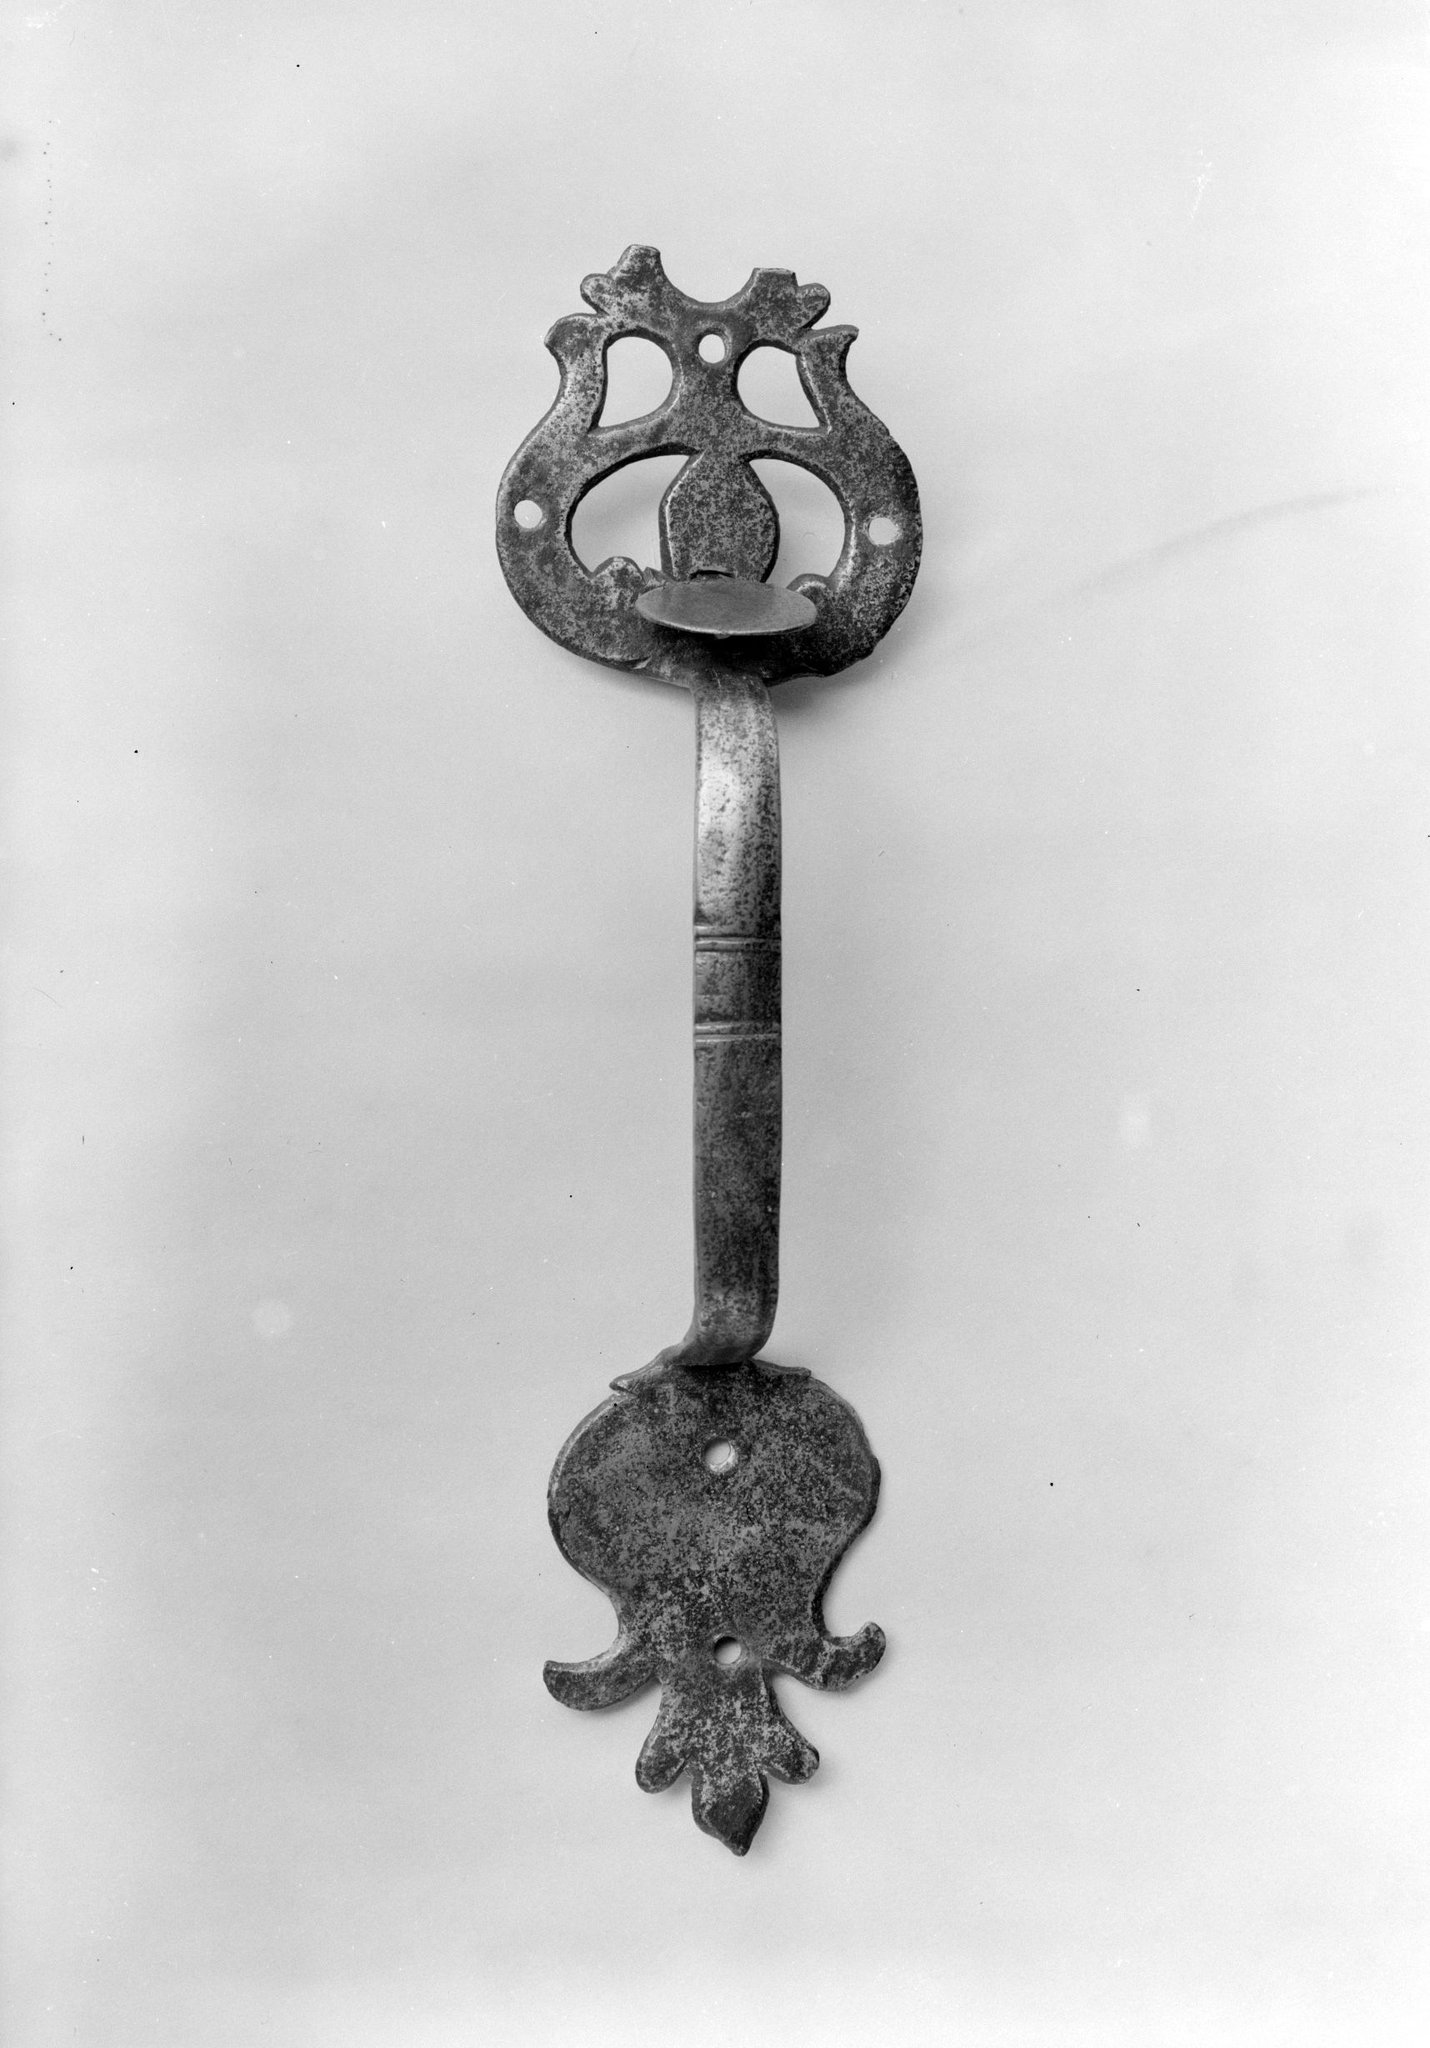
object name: latch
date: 1700-1800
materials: iron